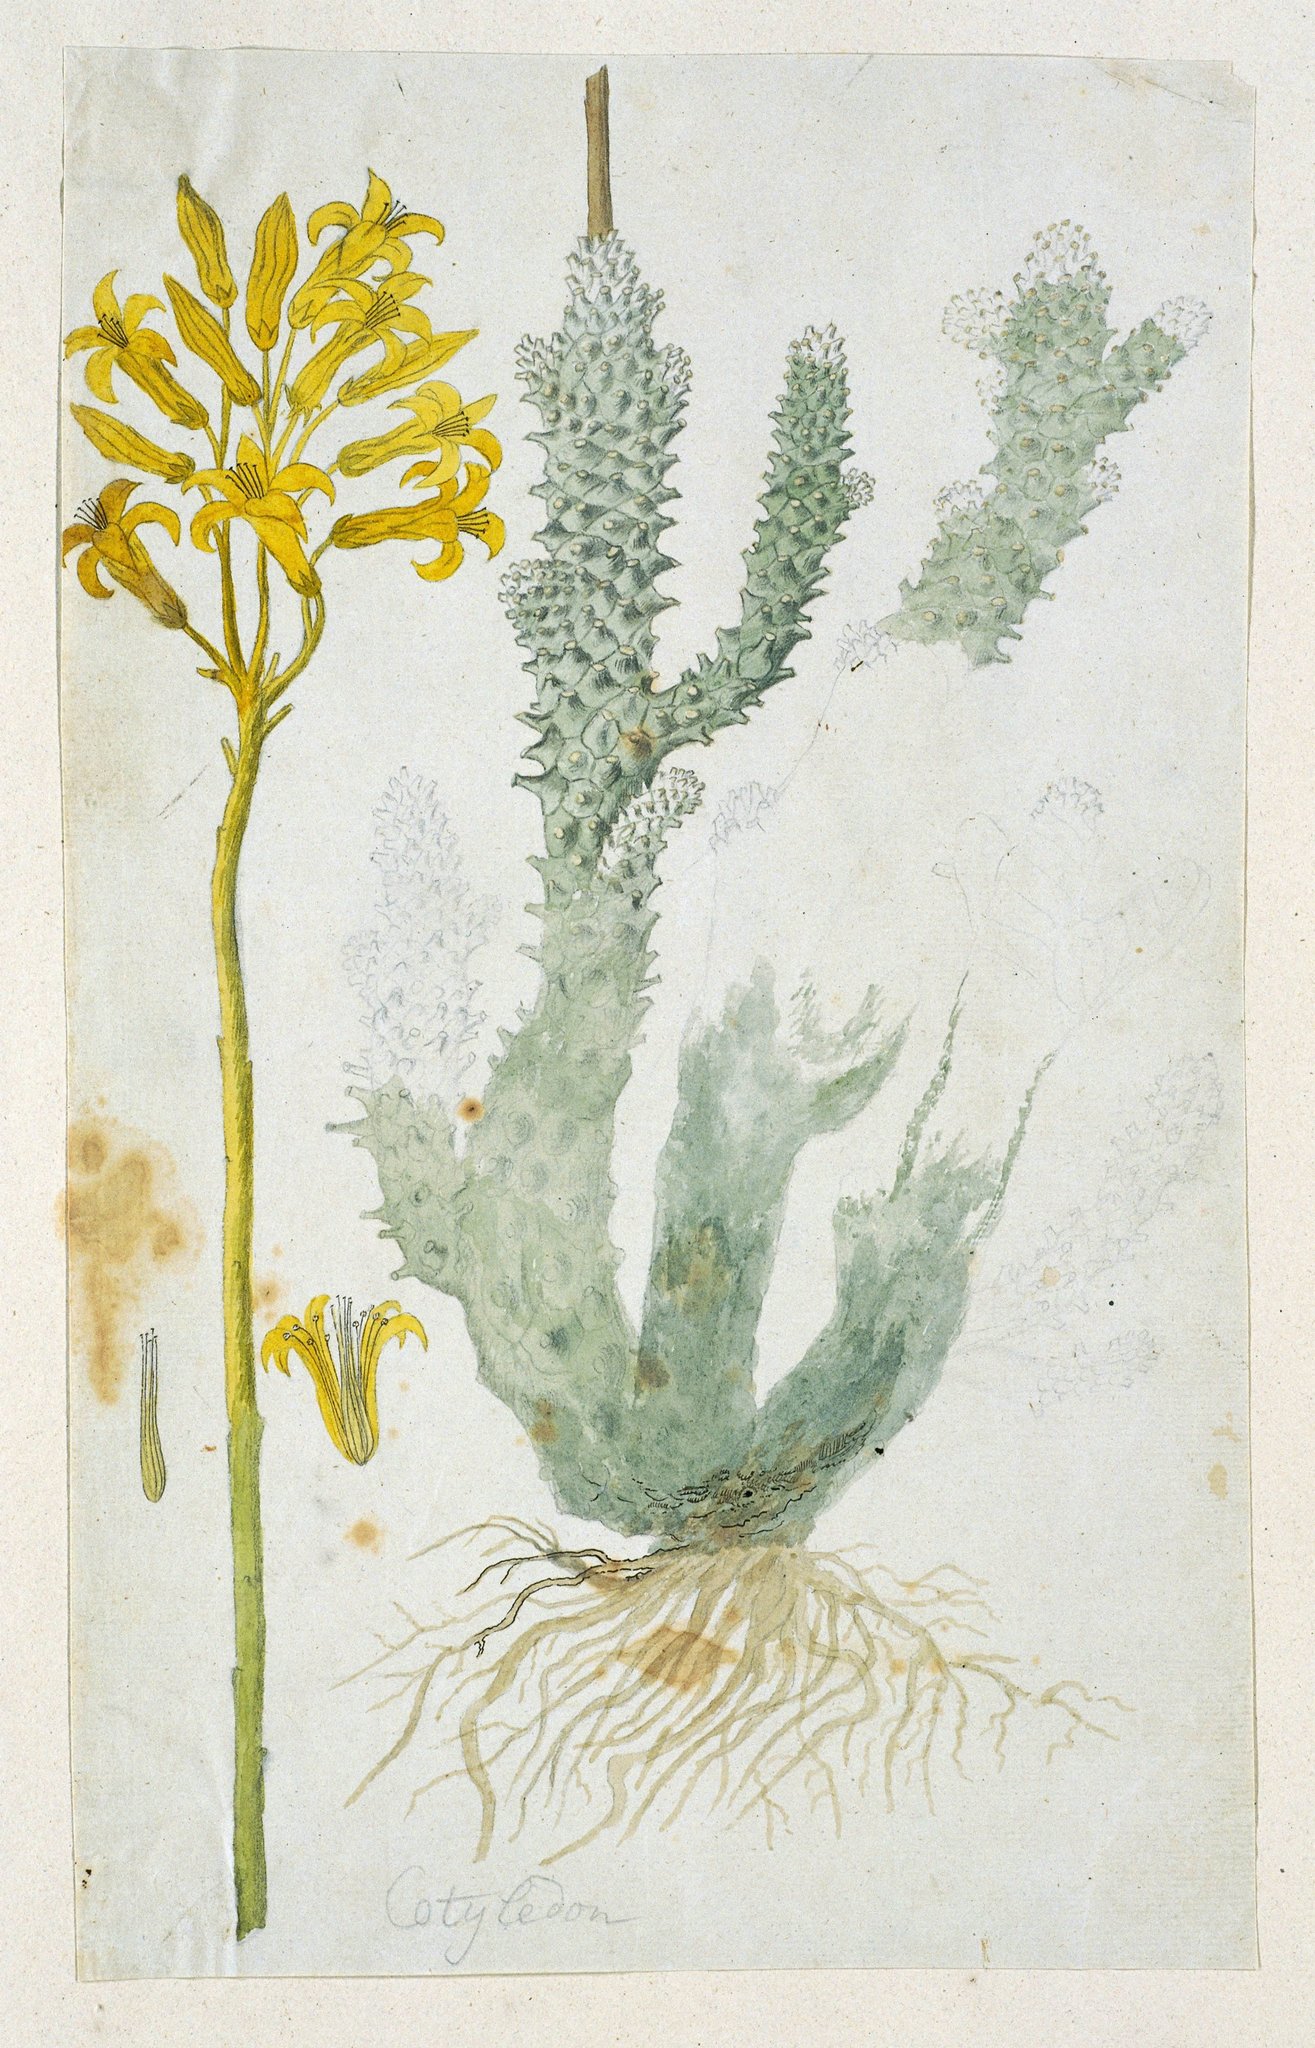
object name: album leaf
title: Tylecodon cacalioides (L.f.) Toelkenken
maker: robert jacob gordon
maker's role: draughtsman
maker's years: 1743-1795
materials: chalk, ink, paper, pencil, watercolor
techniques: brush, pen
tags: plants; vegetation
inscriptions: annotation: ‘Cotyledon’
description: De tekening is gemaakt voor of tijdens een van Gordon's vier expedities door de Kaapprovincie, van oktober 1777 tot maart 1786. Sommige (soort)namen kunnen zijn gewijzigd, gezien reorganisatie in plantentaxonomie gedurende de afgelopen jaren.